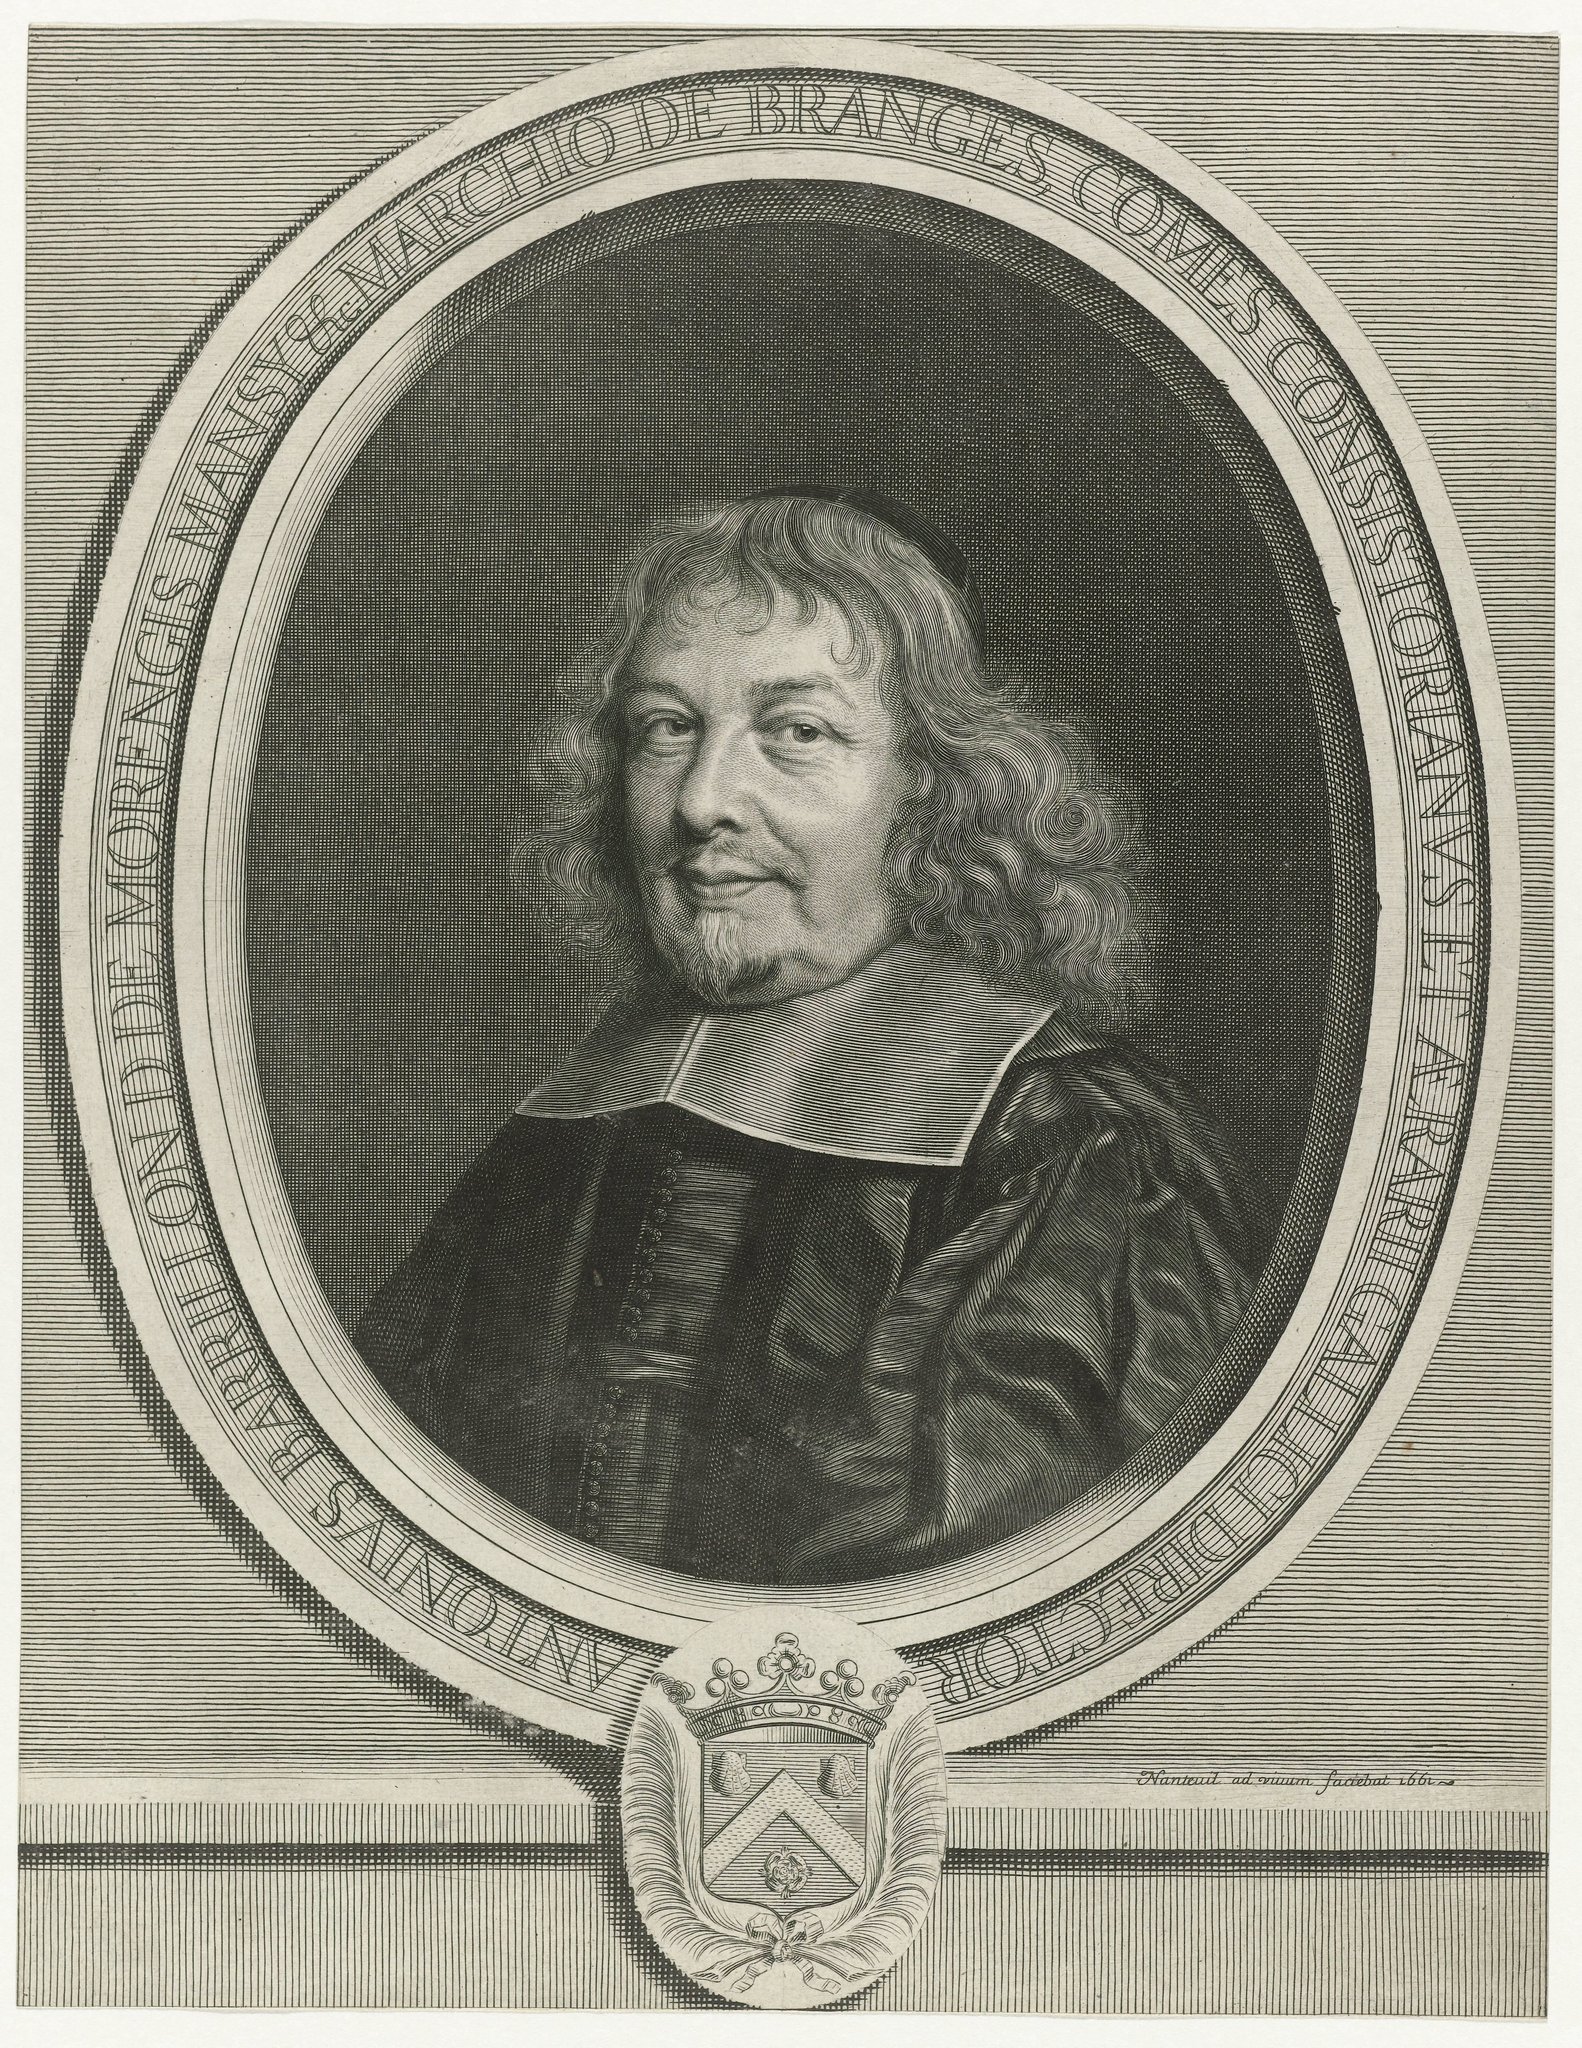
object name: print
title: Portret van Antoine Barrillon de Morangis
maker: robert nanteuil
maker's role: print maker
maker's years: 1623-1678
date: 1661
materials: paper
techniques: engraving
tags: antoine barrillon de morangis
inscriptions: date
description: Buste naar links, in ovale lijst met randschrift. Wapen middenonder.